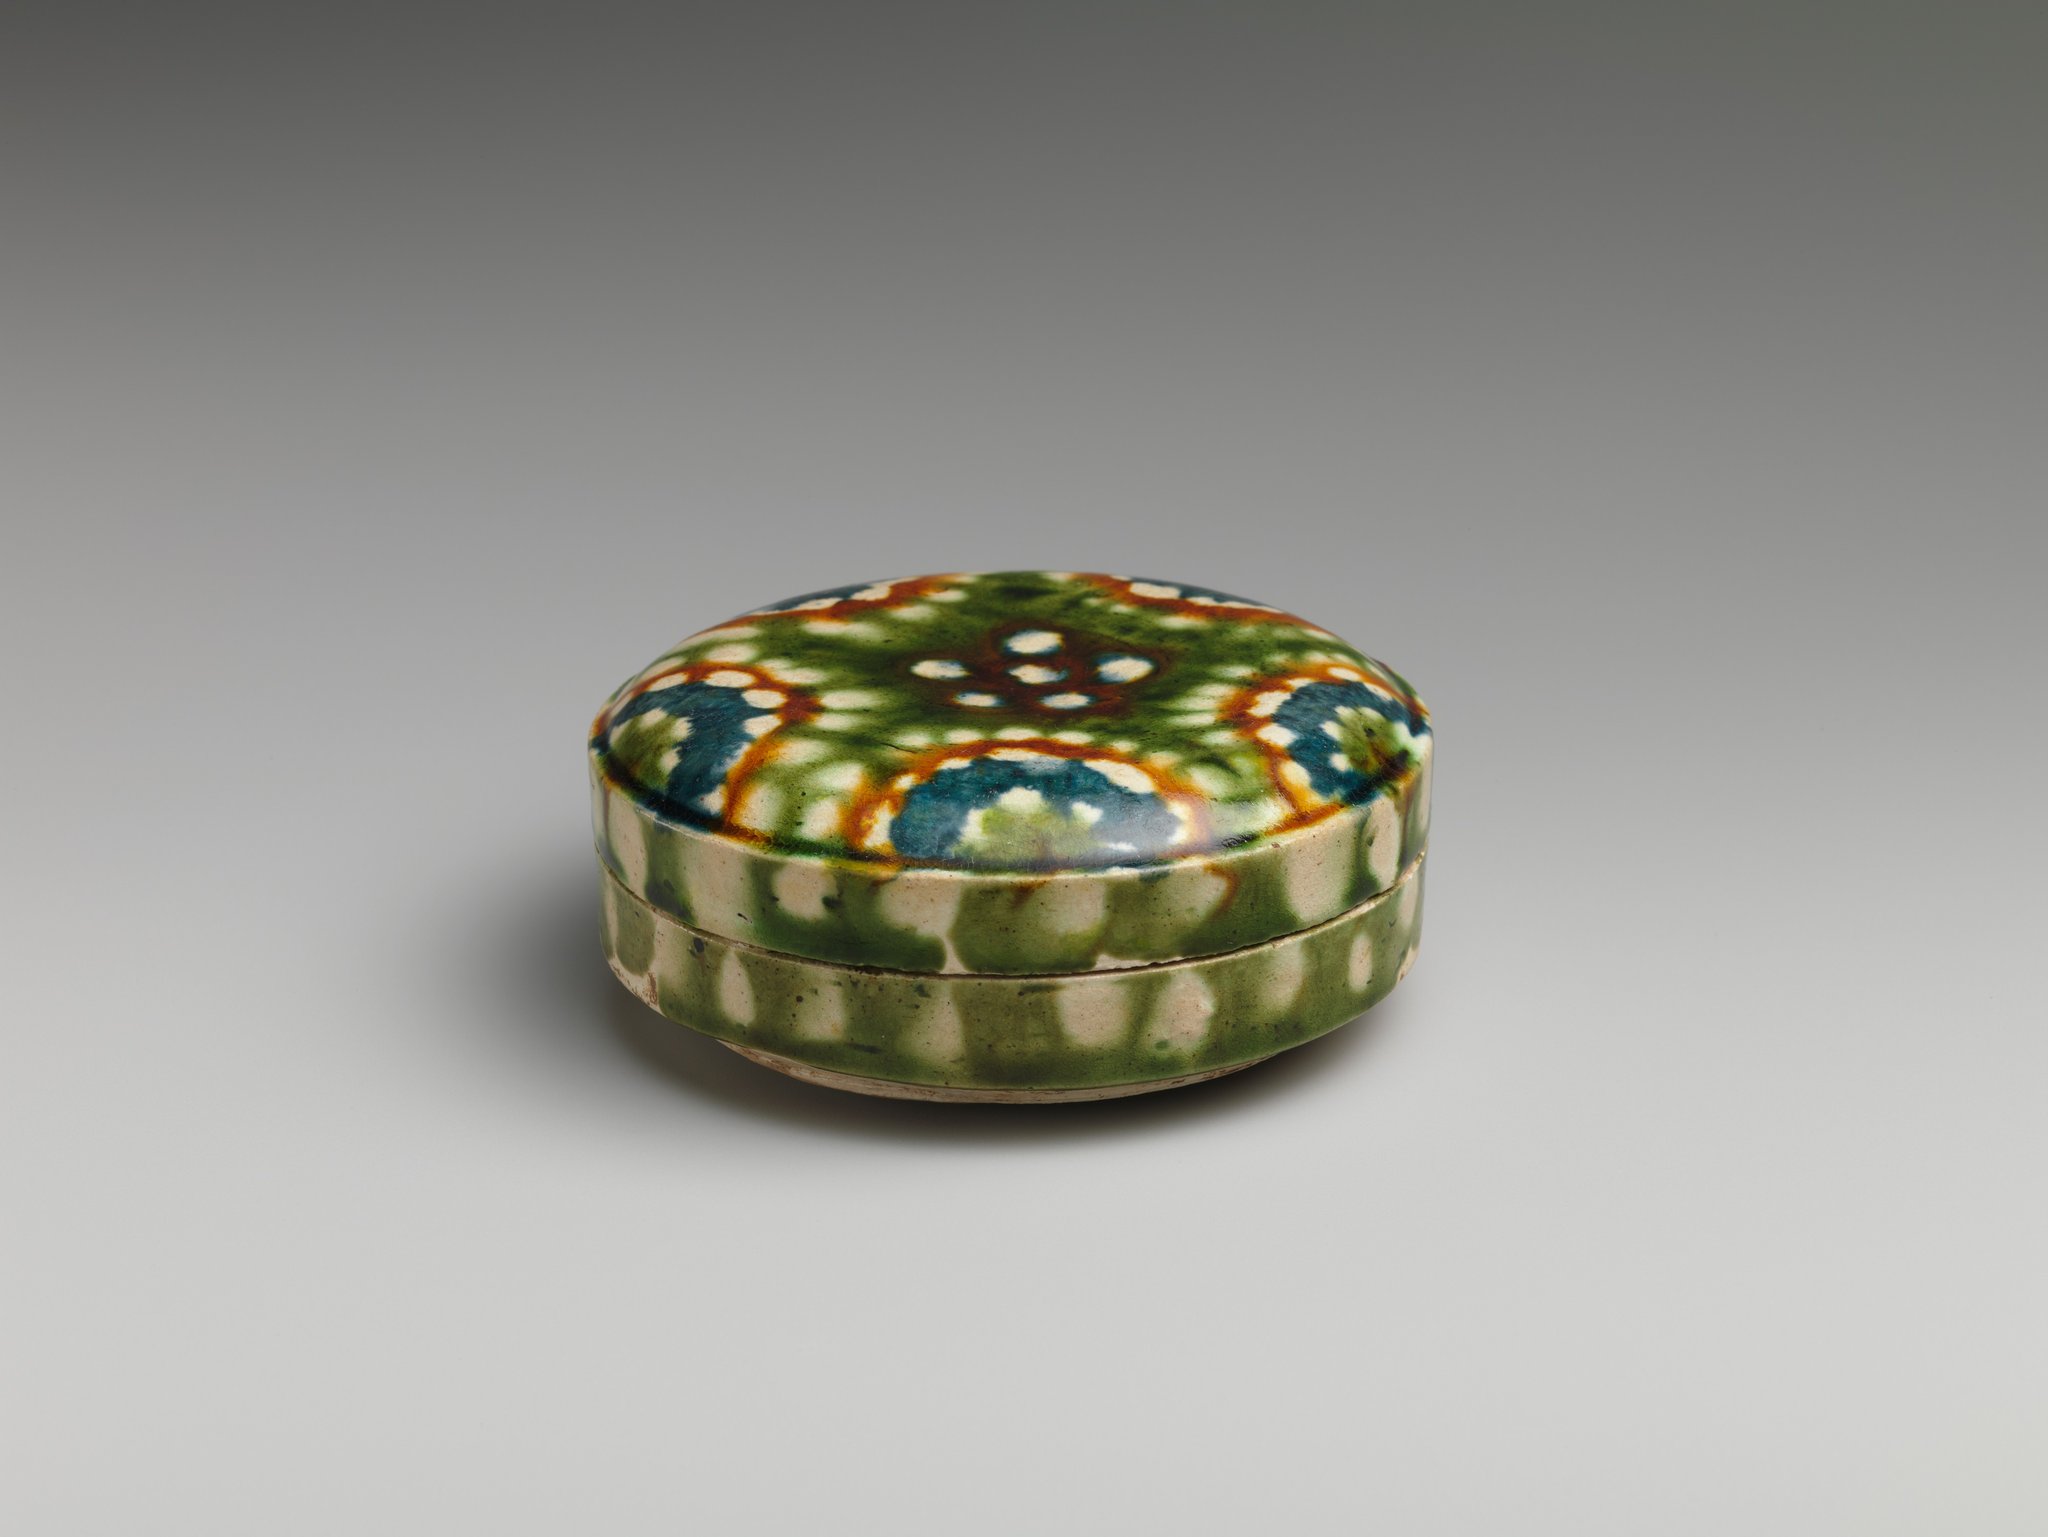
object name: box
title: Cosmetics box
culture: chinese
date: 701-800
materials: earthenware, glaze, marble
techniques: veneering